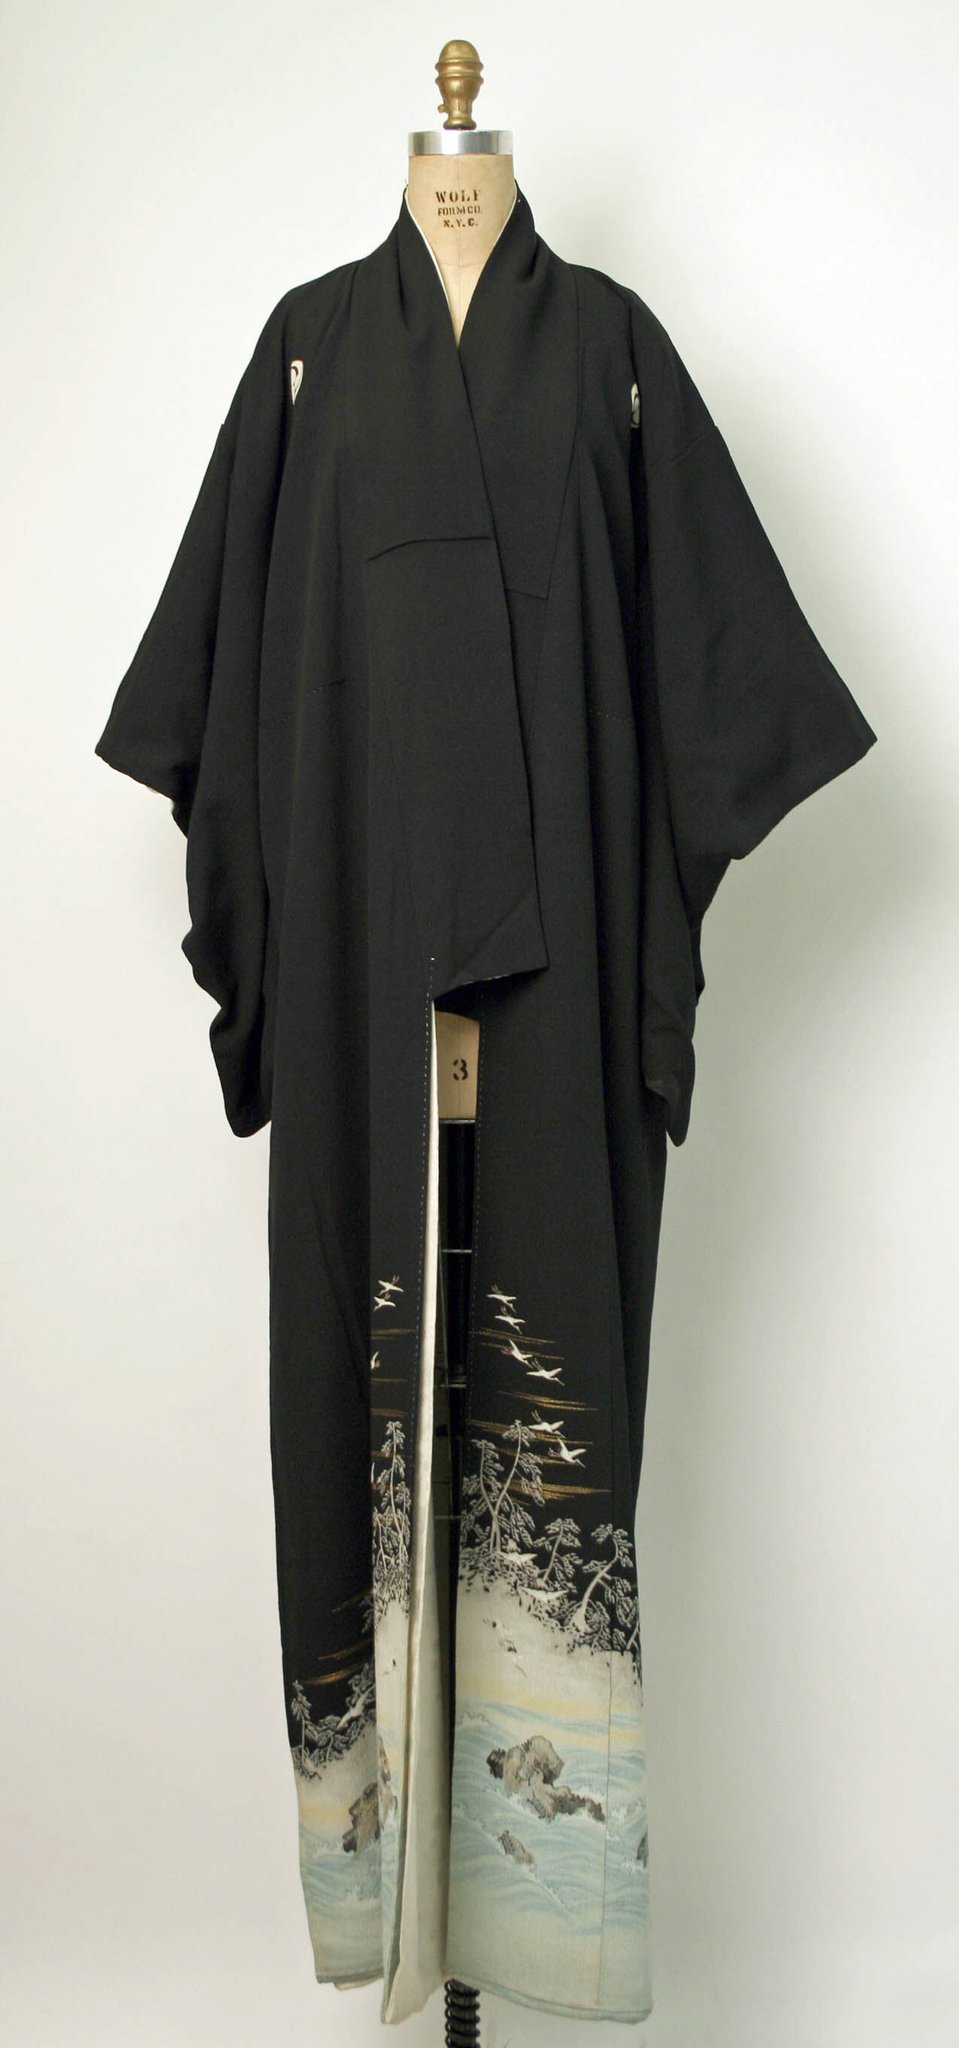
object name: kimono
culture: japanese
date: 1800-1941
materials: silk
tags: birds,waves